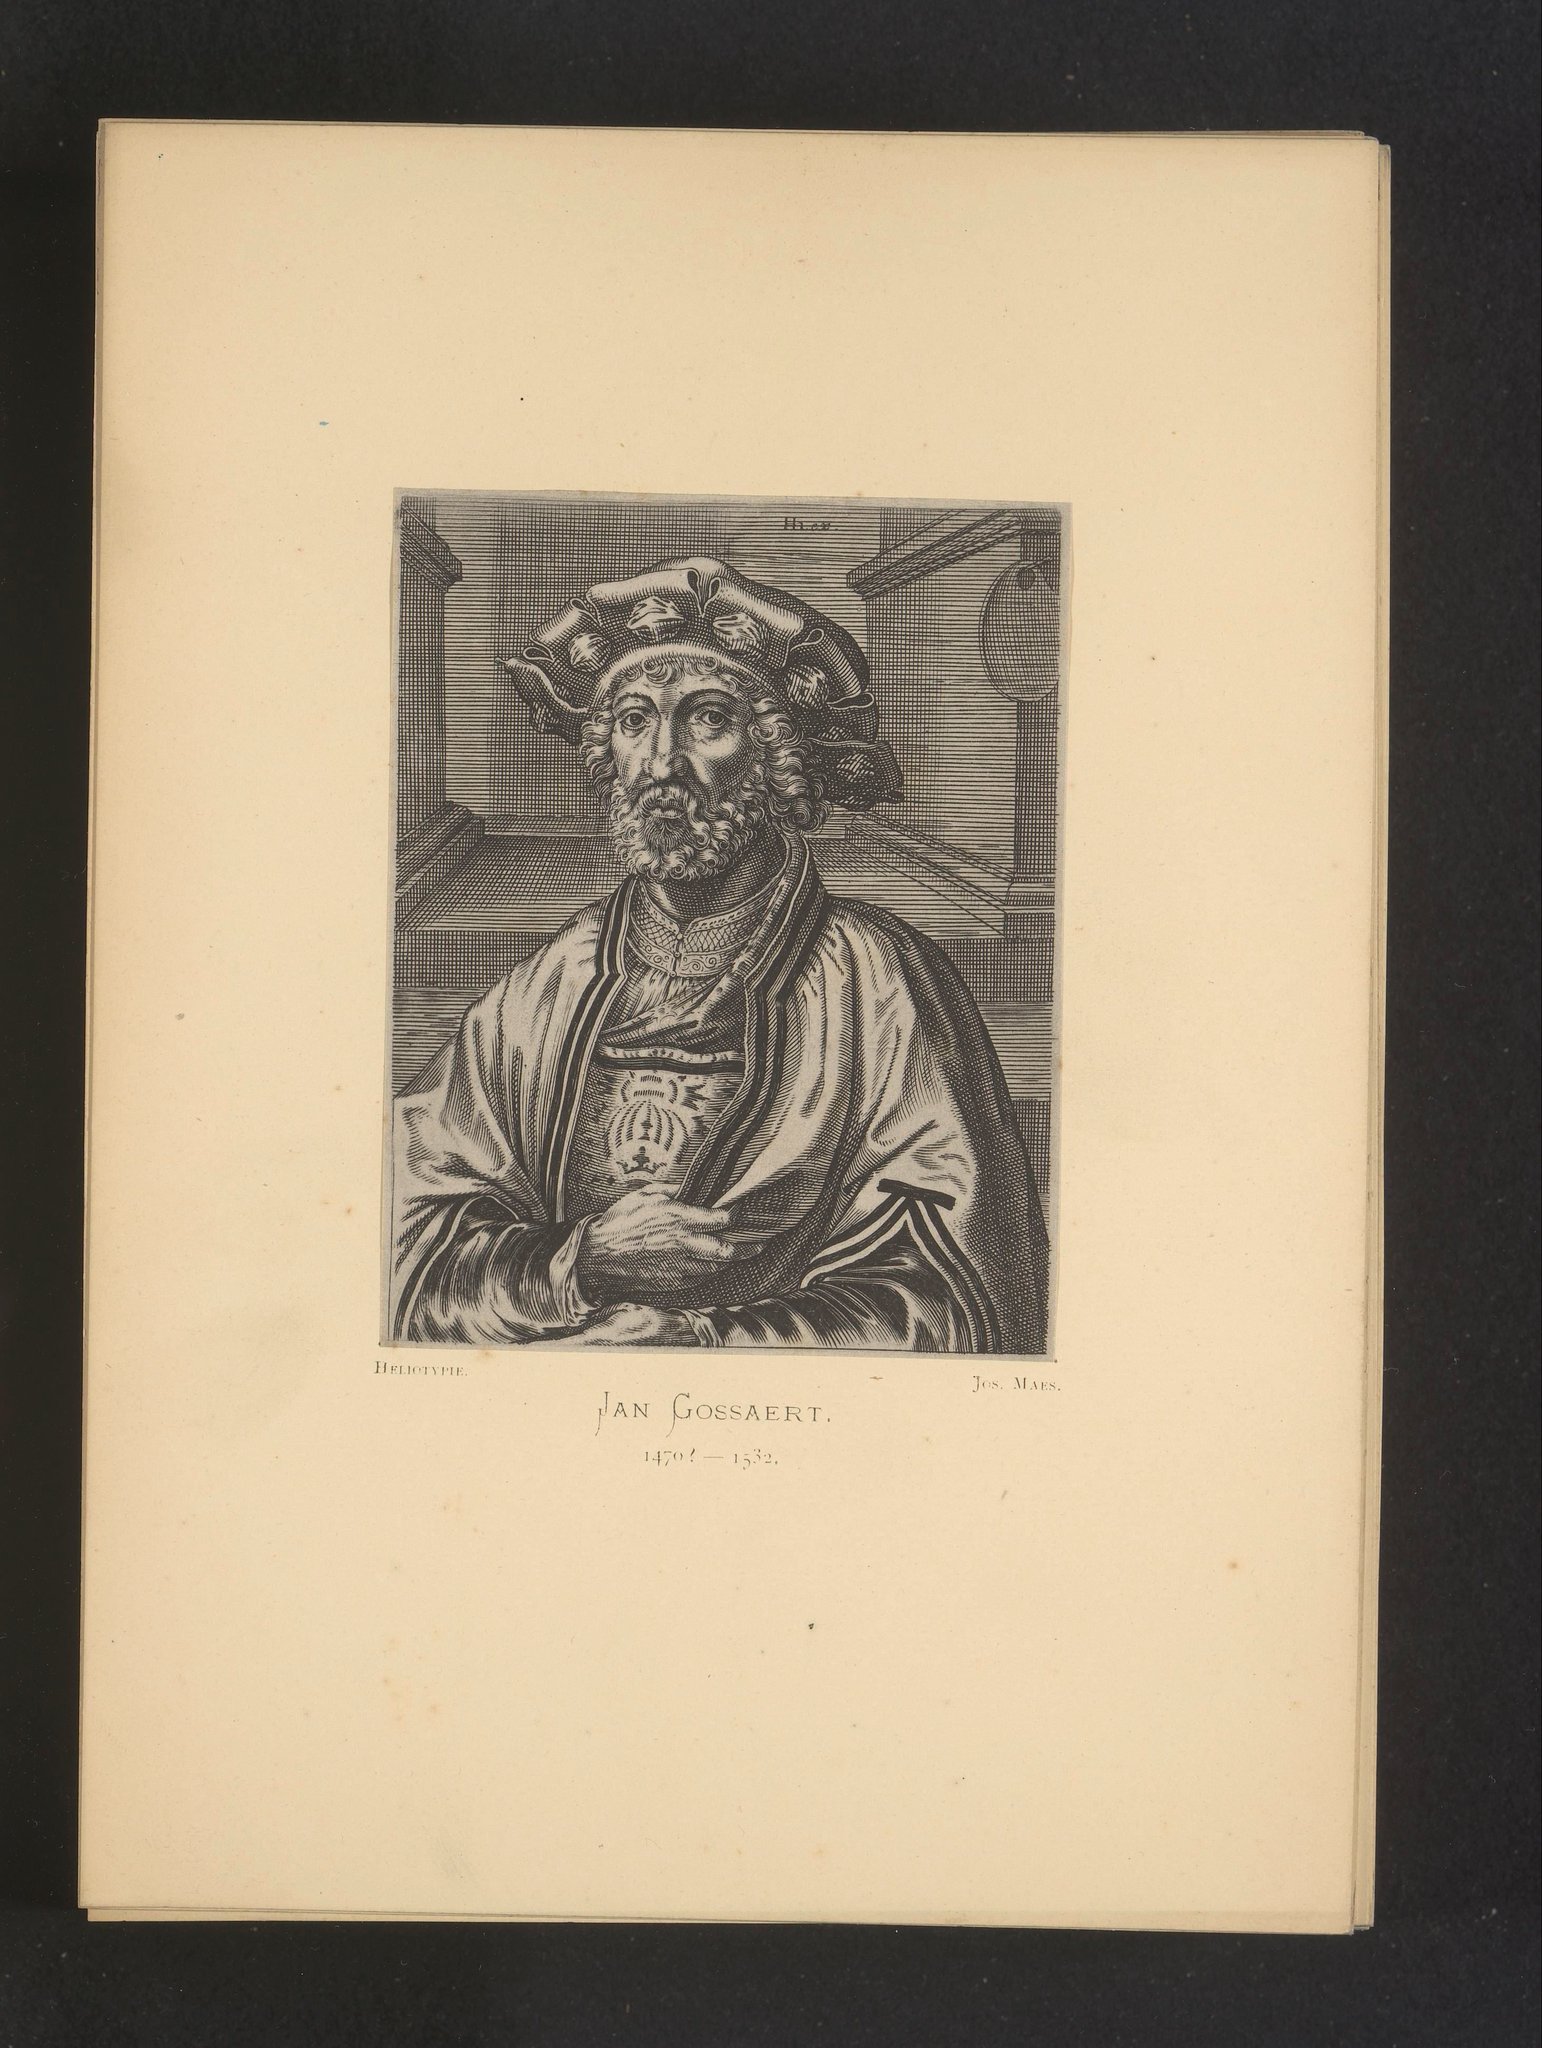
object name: photomechanical print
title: Quinten Massijs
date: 1872-1877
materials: cardboard, paper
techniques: photograph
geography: antwerp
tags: painter, print maker, draughtsman, jan gossart, historical persons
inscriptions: inscription: ‘1470? - 1532.’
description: Deze prent maakt deel uit van een omslag met 150 prenten en een katern met een lijst van afbeeldingen.